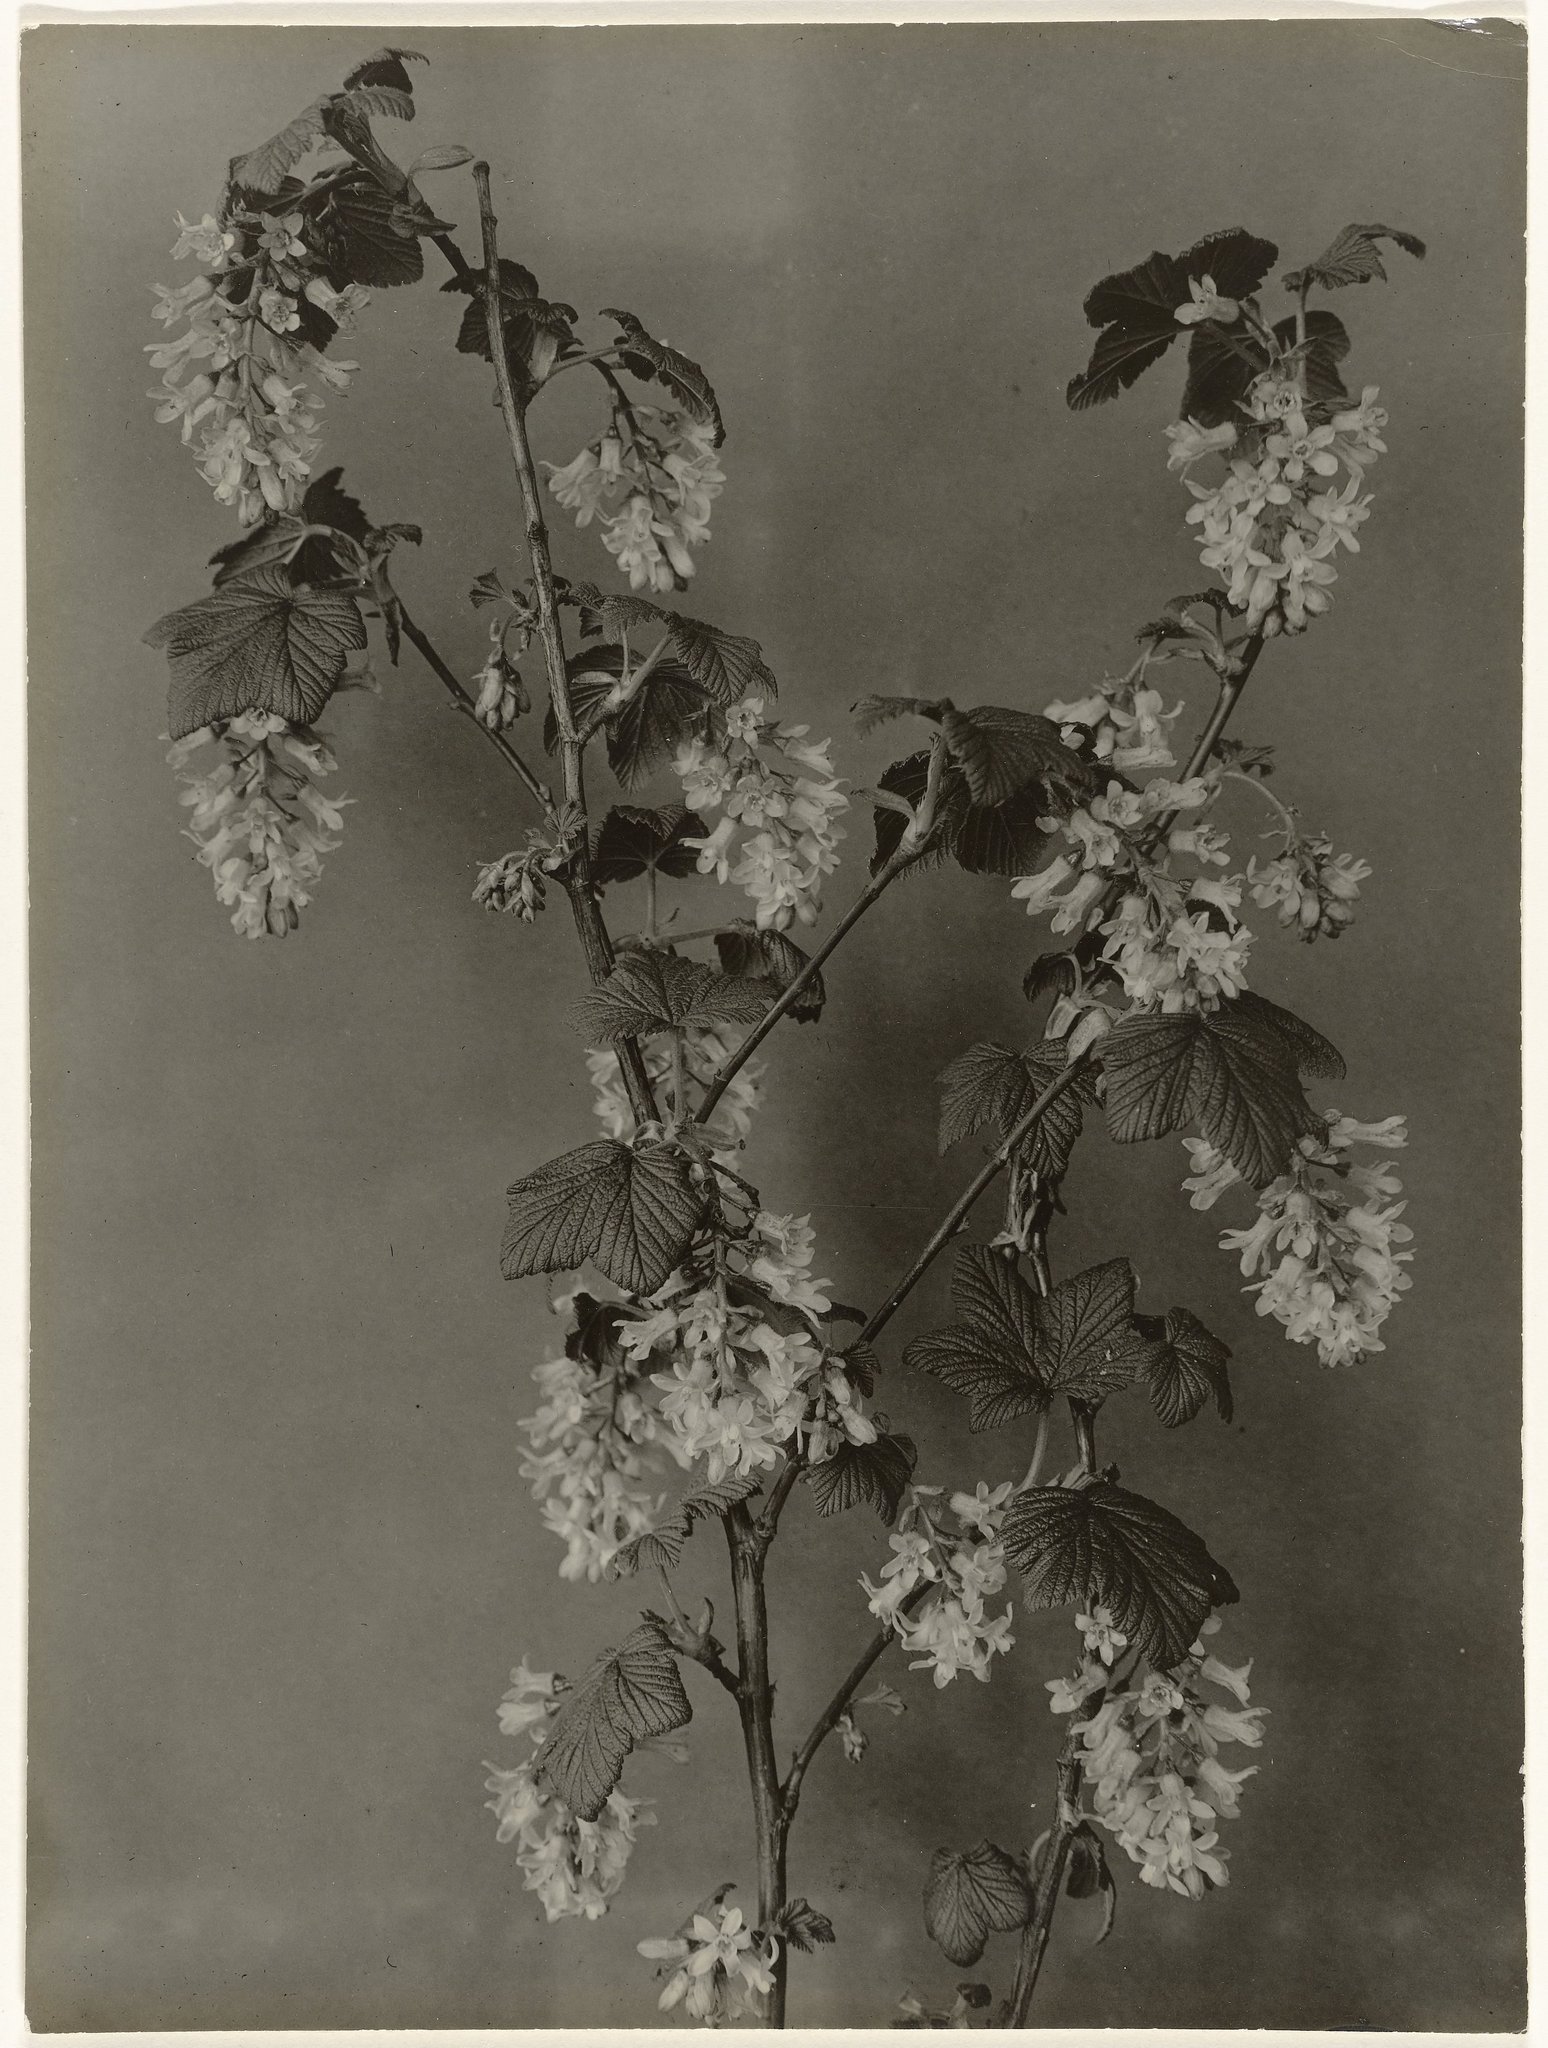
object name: photograph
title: Tak Ribes Sanguineum tegen egale achtergrond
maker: richard tepe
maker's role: fotograaf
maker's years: 1864-1952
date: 1900-1940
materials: photographic support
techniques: gelatin silver print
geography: netherlands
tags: flowers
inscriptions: signature: ‘foto / R. Tepe’, : ‘Ribes Sanguineum / album / bloeiende tak’